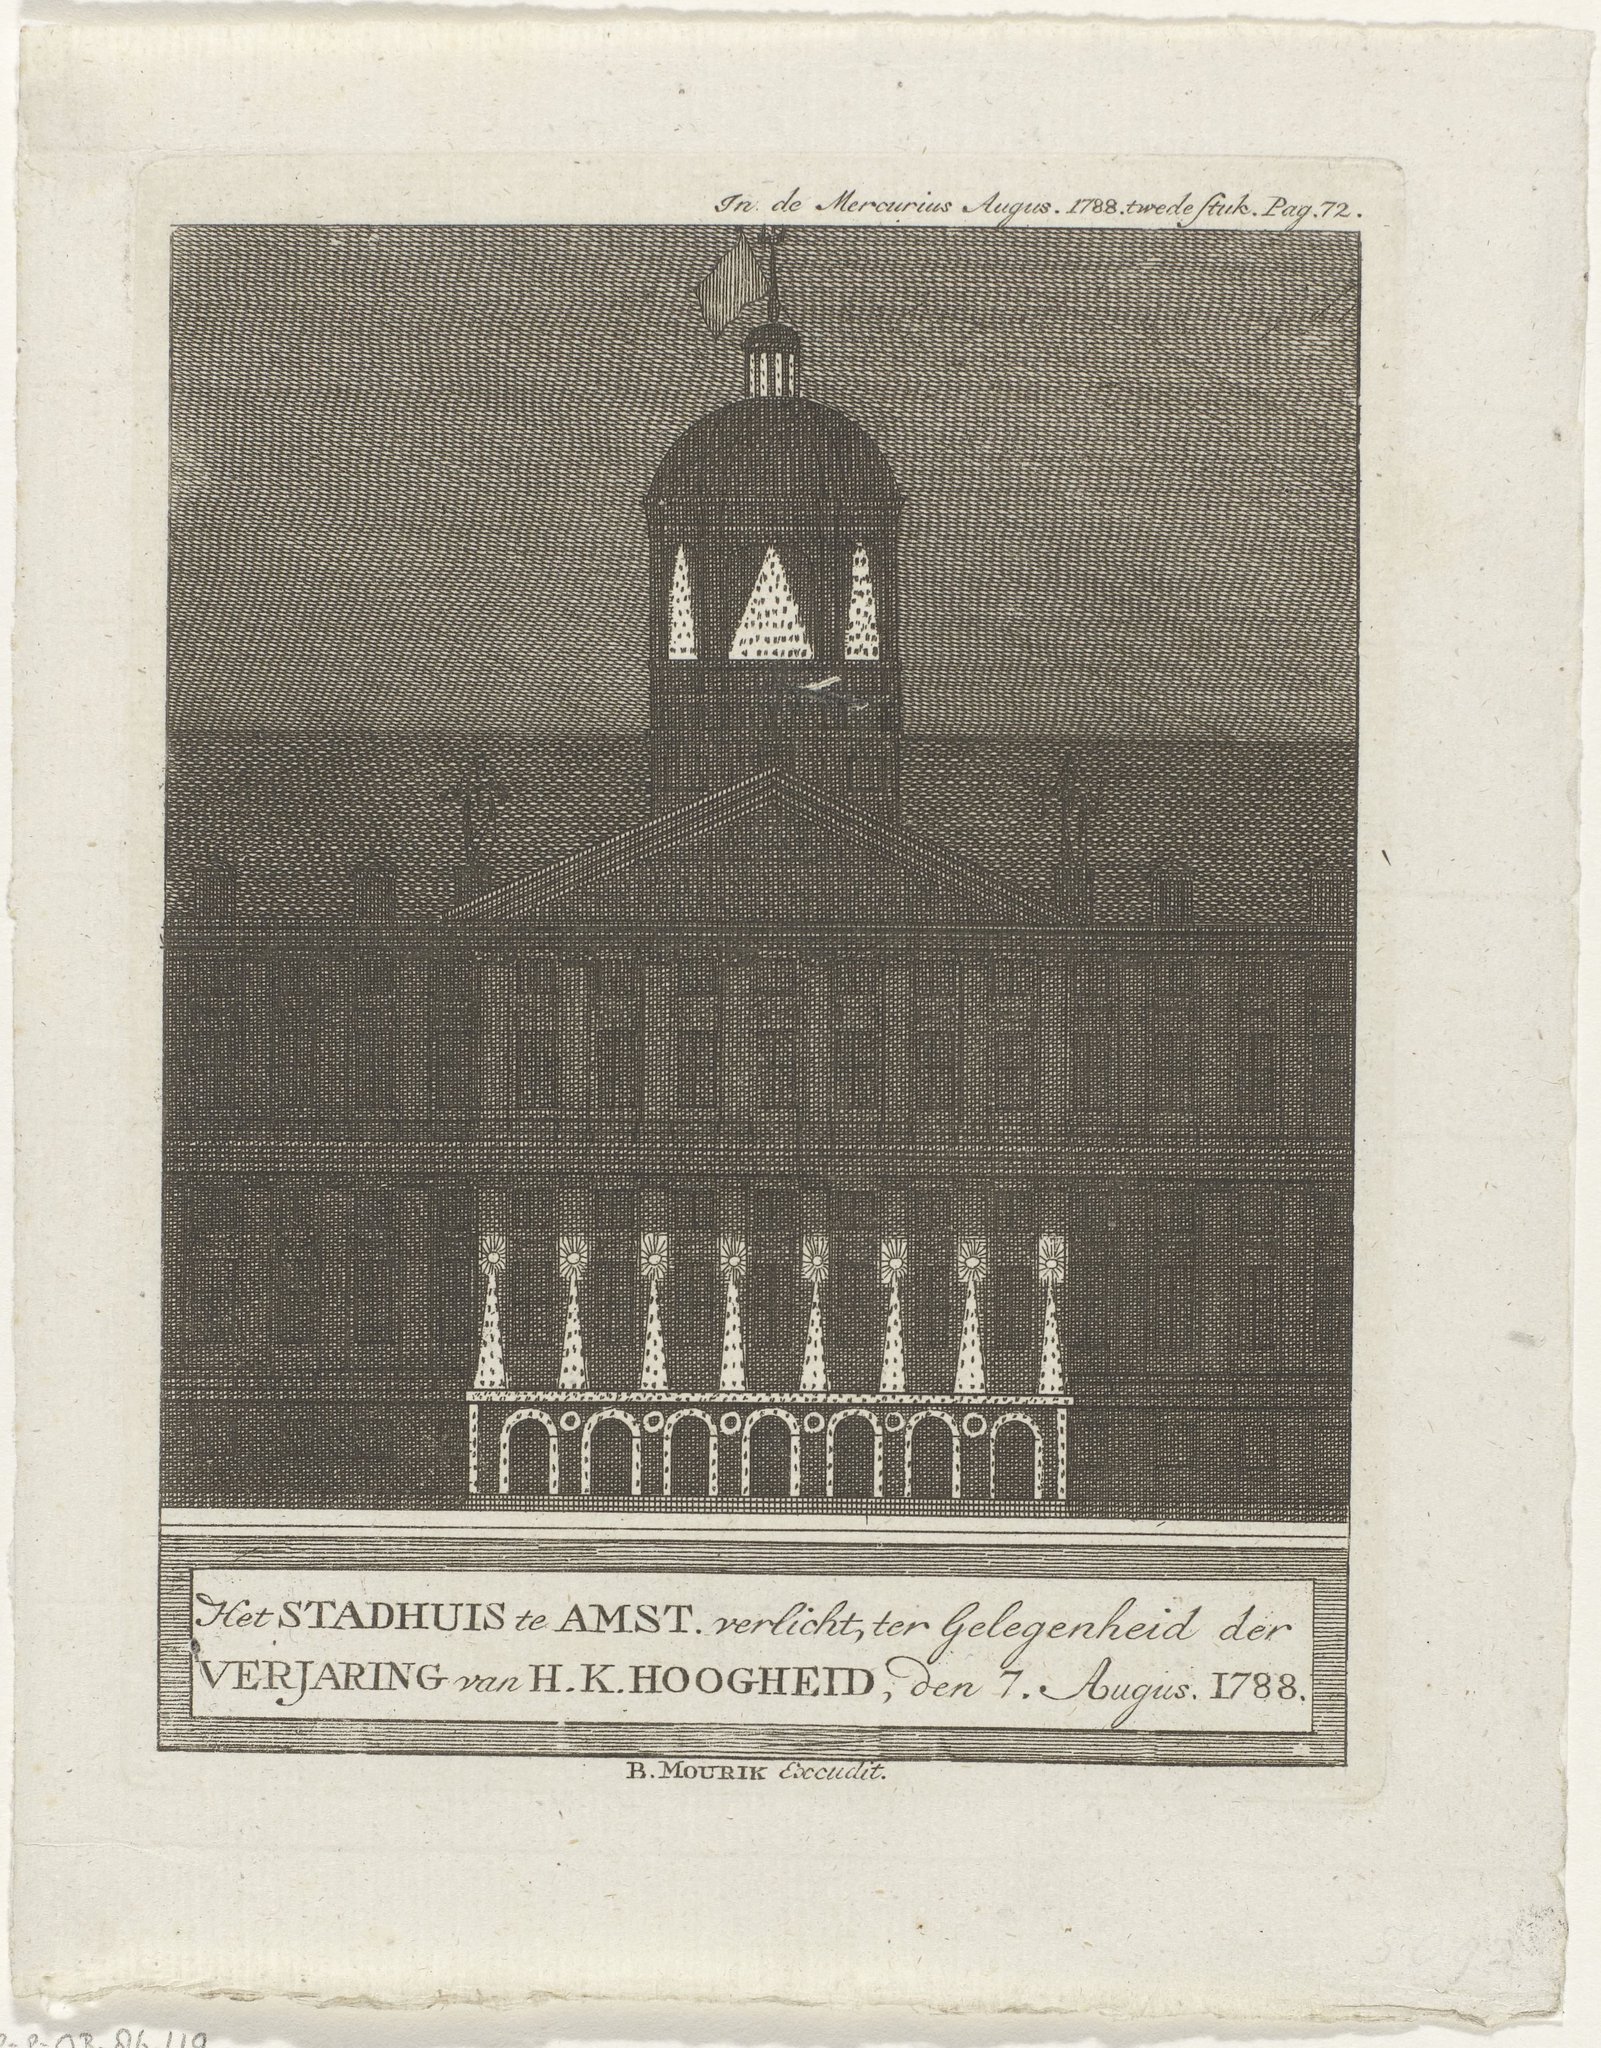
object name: print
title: Illuminatie van het stadhuis te Amsterdam, 1788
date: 1789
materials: paper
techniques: etching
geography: northern netherlands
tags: painter, draughtsman, wilhelmina of prussia (princess of orange), public festivities at other royal events, not meant or mentioned above (+ illumination, fire-works ~ festive activities)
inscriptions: collector's mark: Lugt 2228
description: Illuminatie van het stadhuis te Amsterdam, ter gelegenheid van de verjaardag van prinses Wilhelmina van Pruisen op 7 augustus 1788.